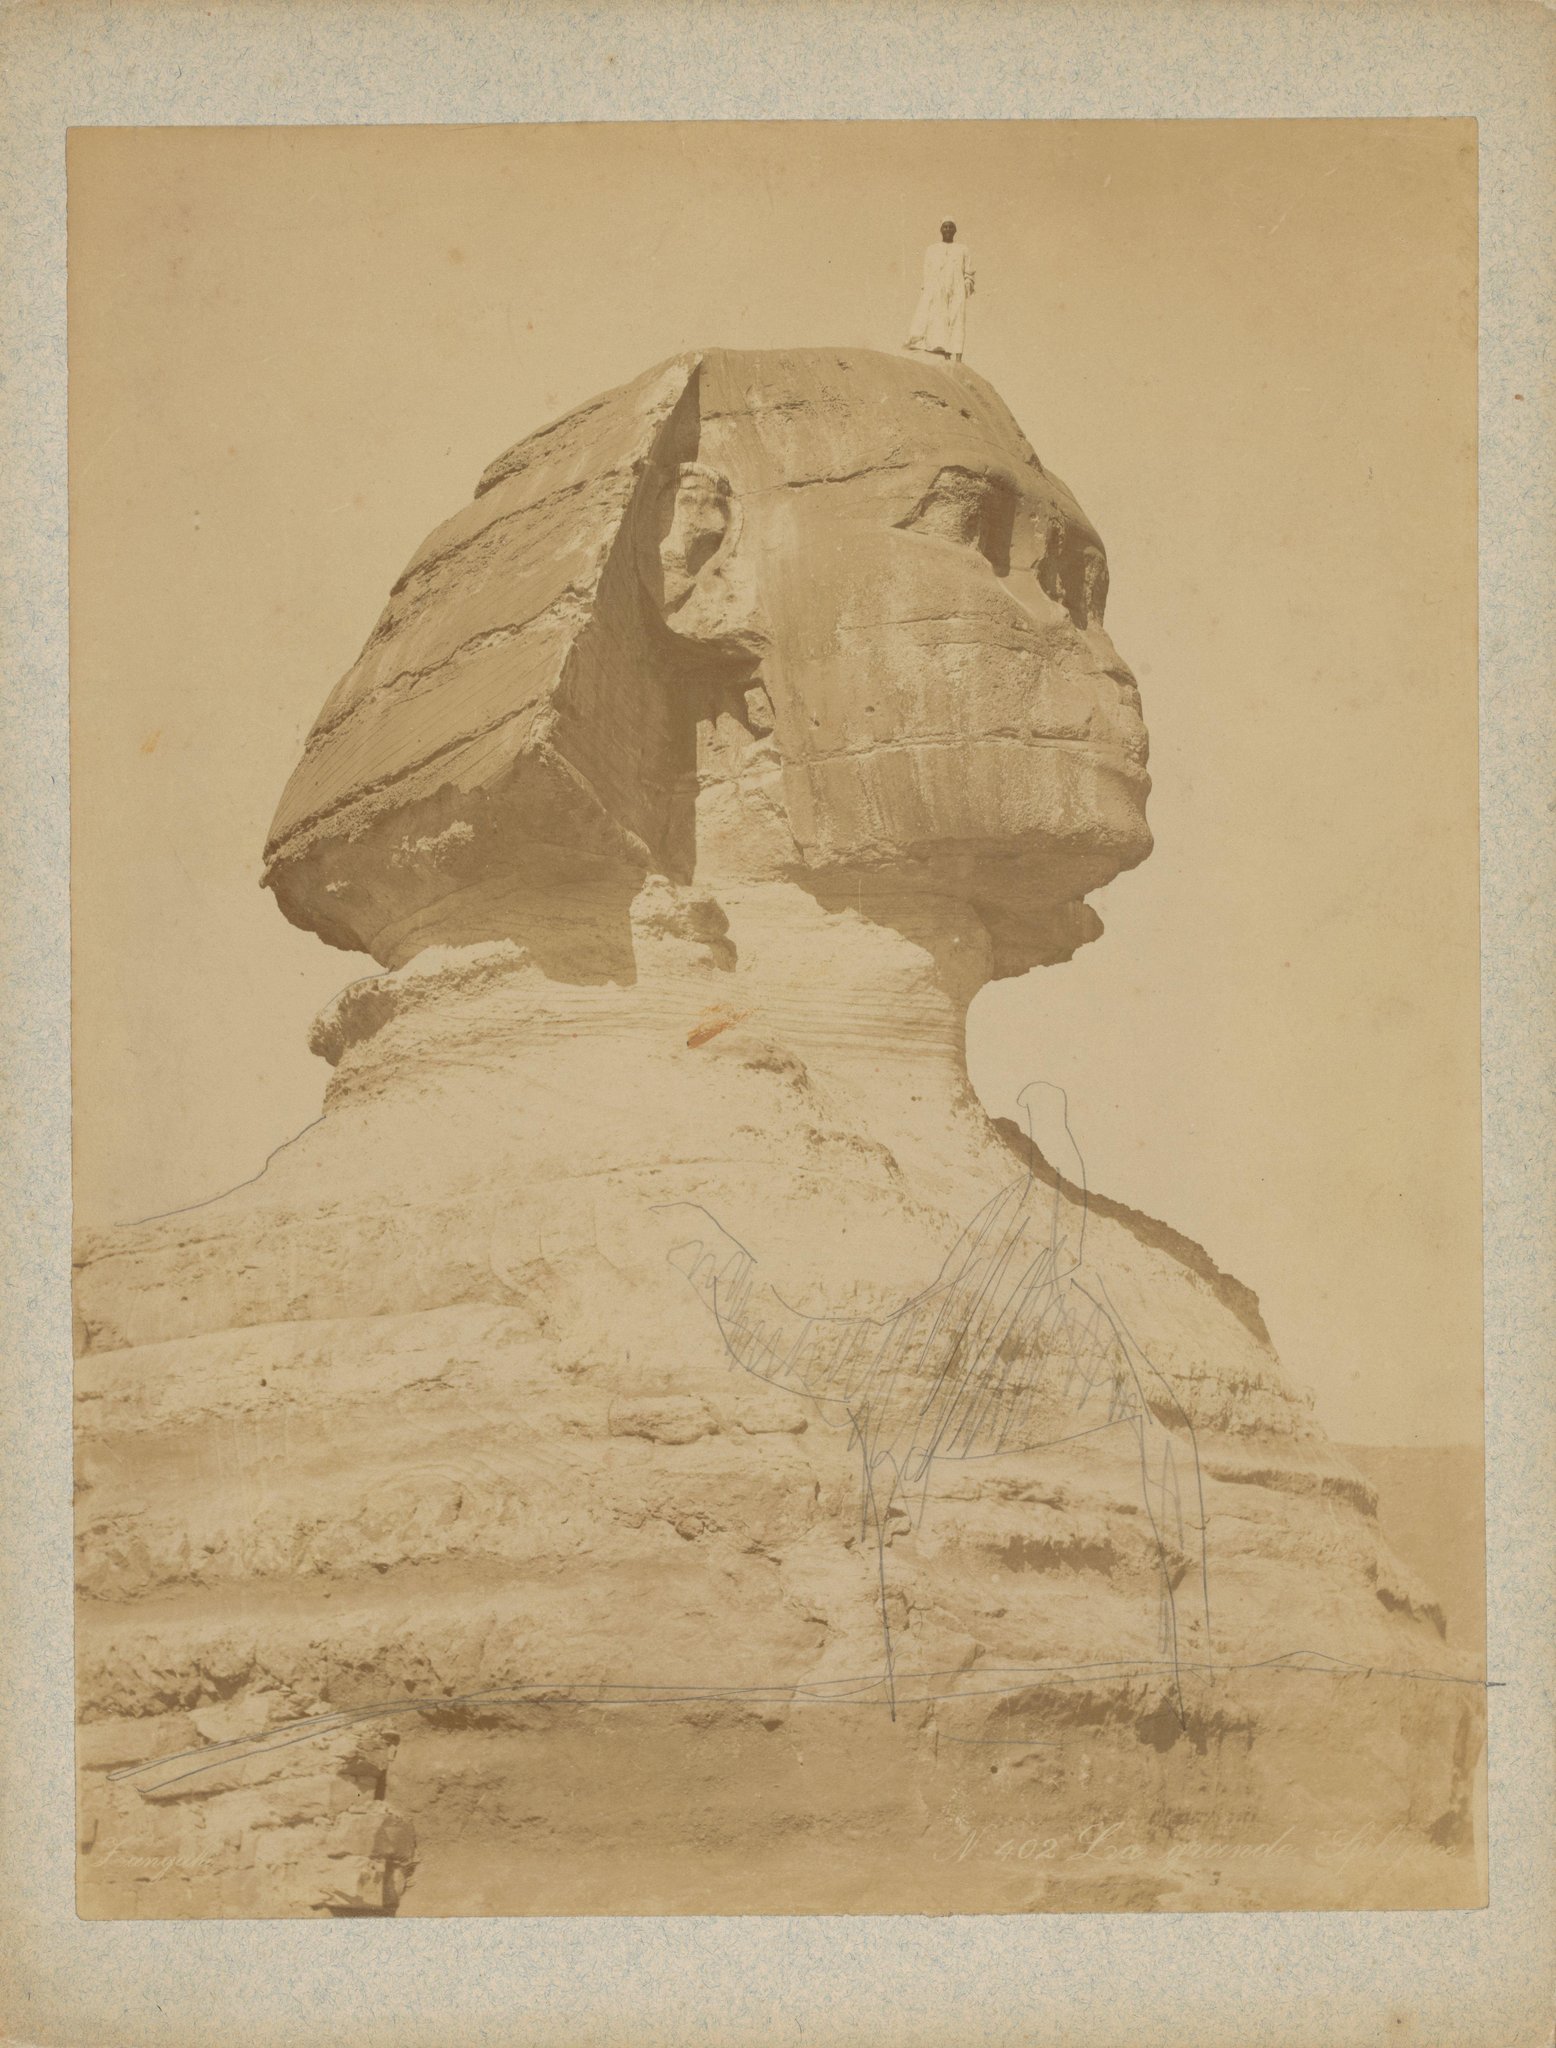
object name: photograph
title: De Sfinx; een man in Oosterse kleding staat op haar hoofd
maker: marius bauer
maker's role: draughtsman, print maker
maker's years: 1867-1932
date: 1890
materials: cardboard, pencil, photographic support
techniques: albumen print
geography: egypt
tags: sfinx van gizeh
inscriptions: inscription: ‘N 402 La grande Sphynx’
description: Op de foto een schets van een man op een kameel.